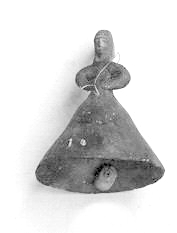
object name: bell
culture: zapotec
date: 1889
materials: clay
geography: mexico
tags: human figures